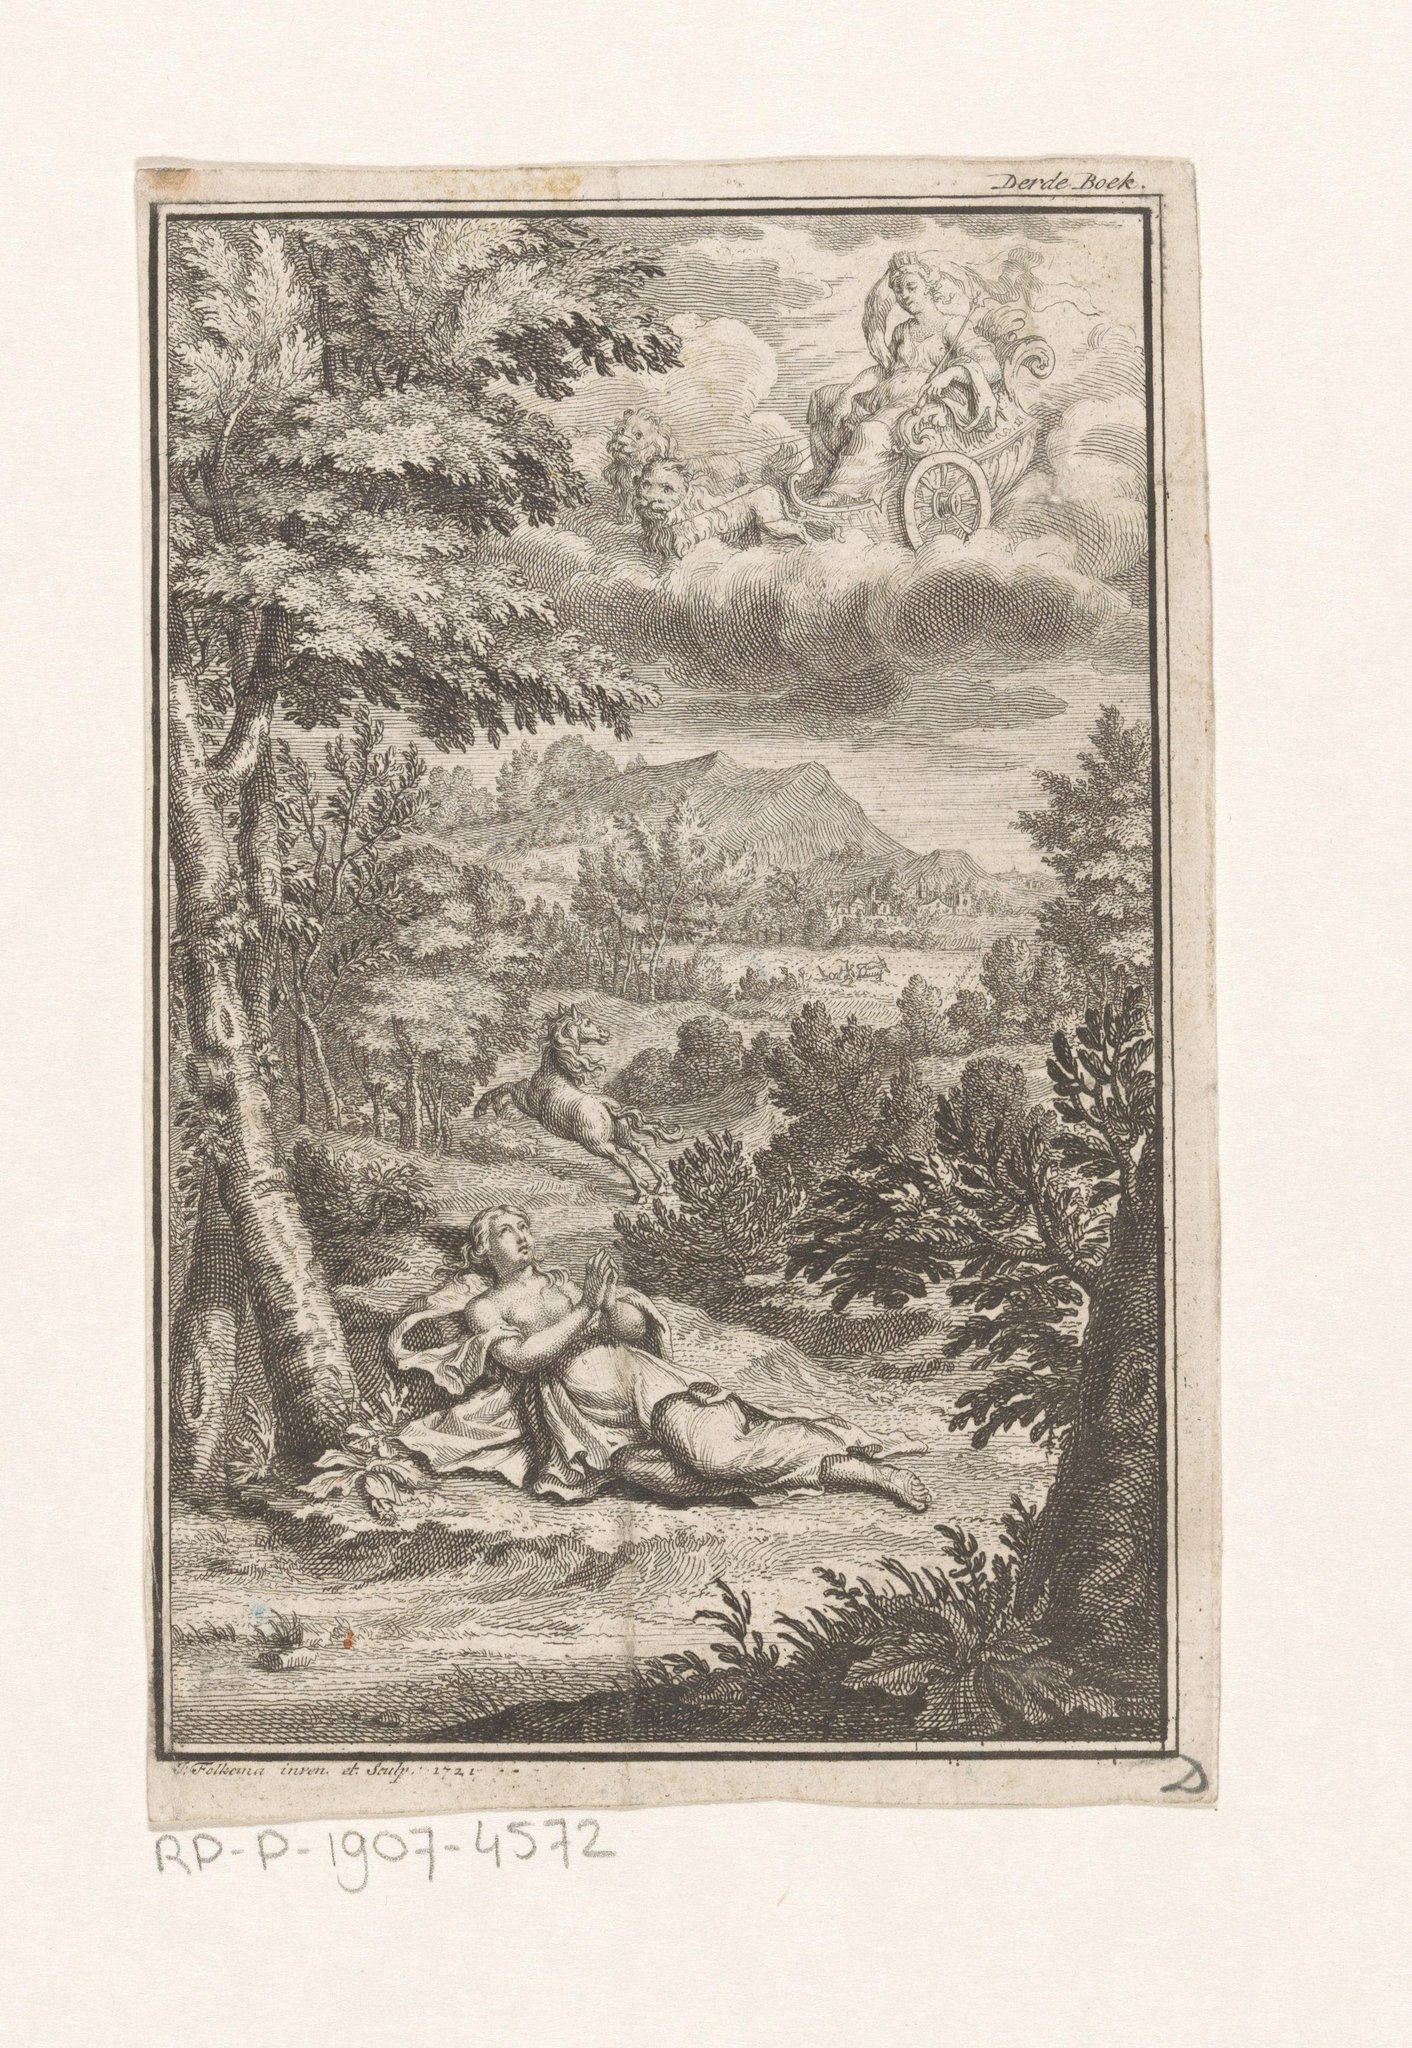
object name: print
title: Biddende vrouw in de natuur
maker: jacob folkema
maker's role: draughtsman, print maker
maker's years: 1692-1767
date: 1721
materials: paper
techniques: etching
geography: northern netherlands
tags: rhea, one person praying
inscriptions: collector's mark: Lugt 2228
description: Een vrouw ligt met ontbloot bovenlichaam op haar rug in het gras en heeft met ineengevouwen handen haar blik naar de hemel gericht. In de verte galoppeert een paard. In de wolken zit Rhea op een zegekar voortgetrokken door twee leeuwen, haar hoofd is getooid met een stedekroon, in haar hand houdt ze een scepter vast. Prent rechts boven gemerkt: Derde Boek.